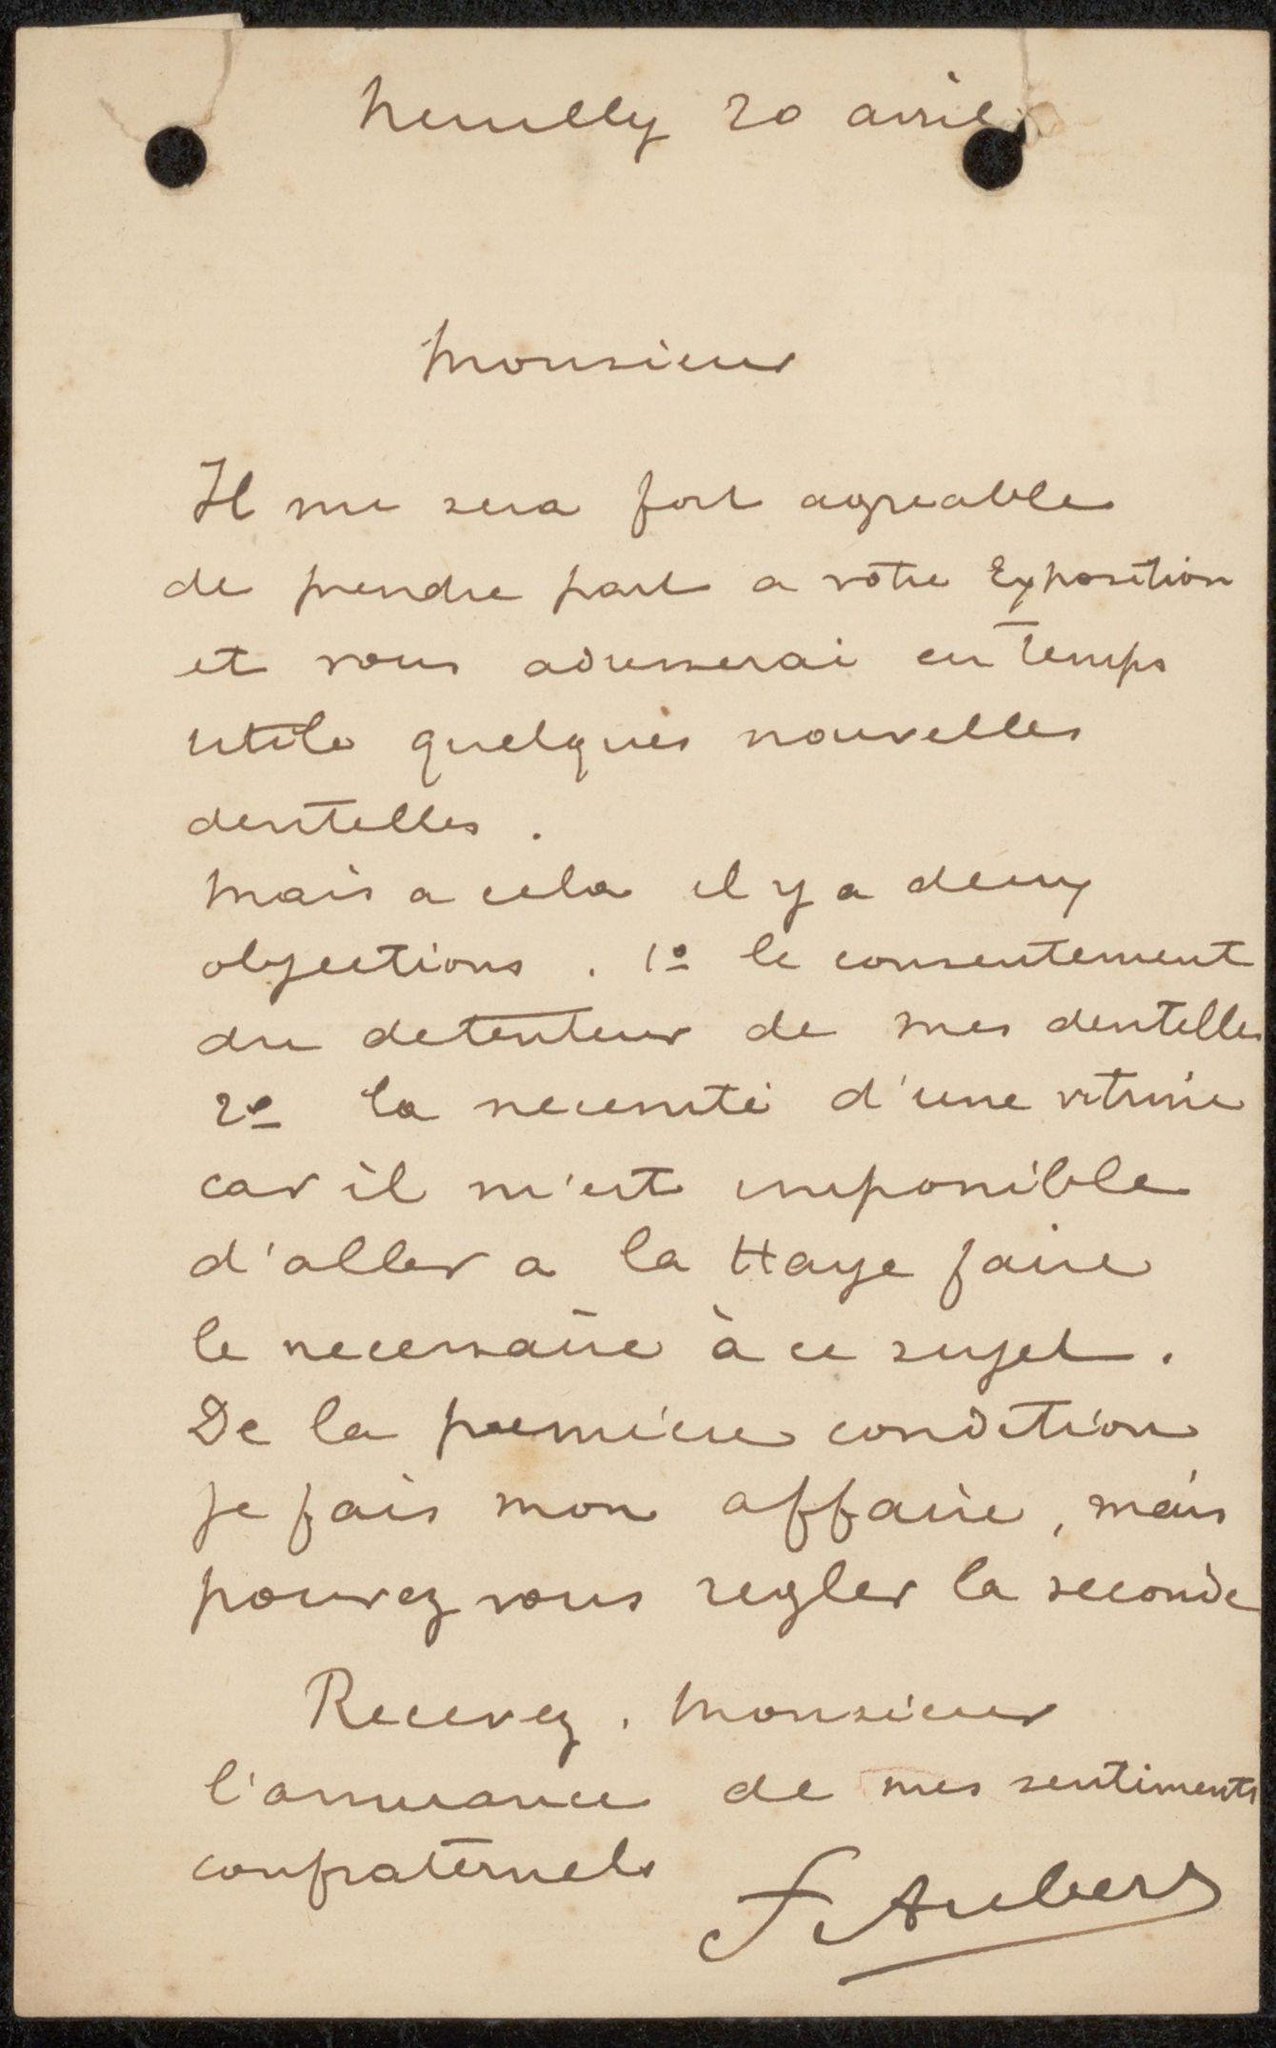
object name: letter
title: Brief aan Philip Zilcken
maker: f. aubert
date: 1867-1930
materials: ink, paper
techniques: pen, writing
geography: neuilly-sur-seine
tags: the hague, draughtsman, philip zilcken, temporary exhibition, 'salon'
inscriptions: collector's mark: ‘RPK’, watermark